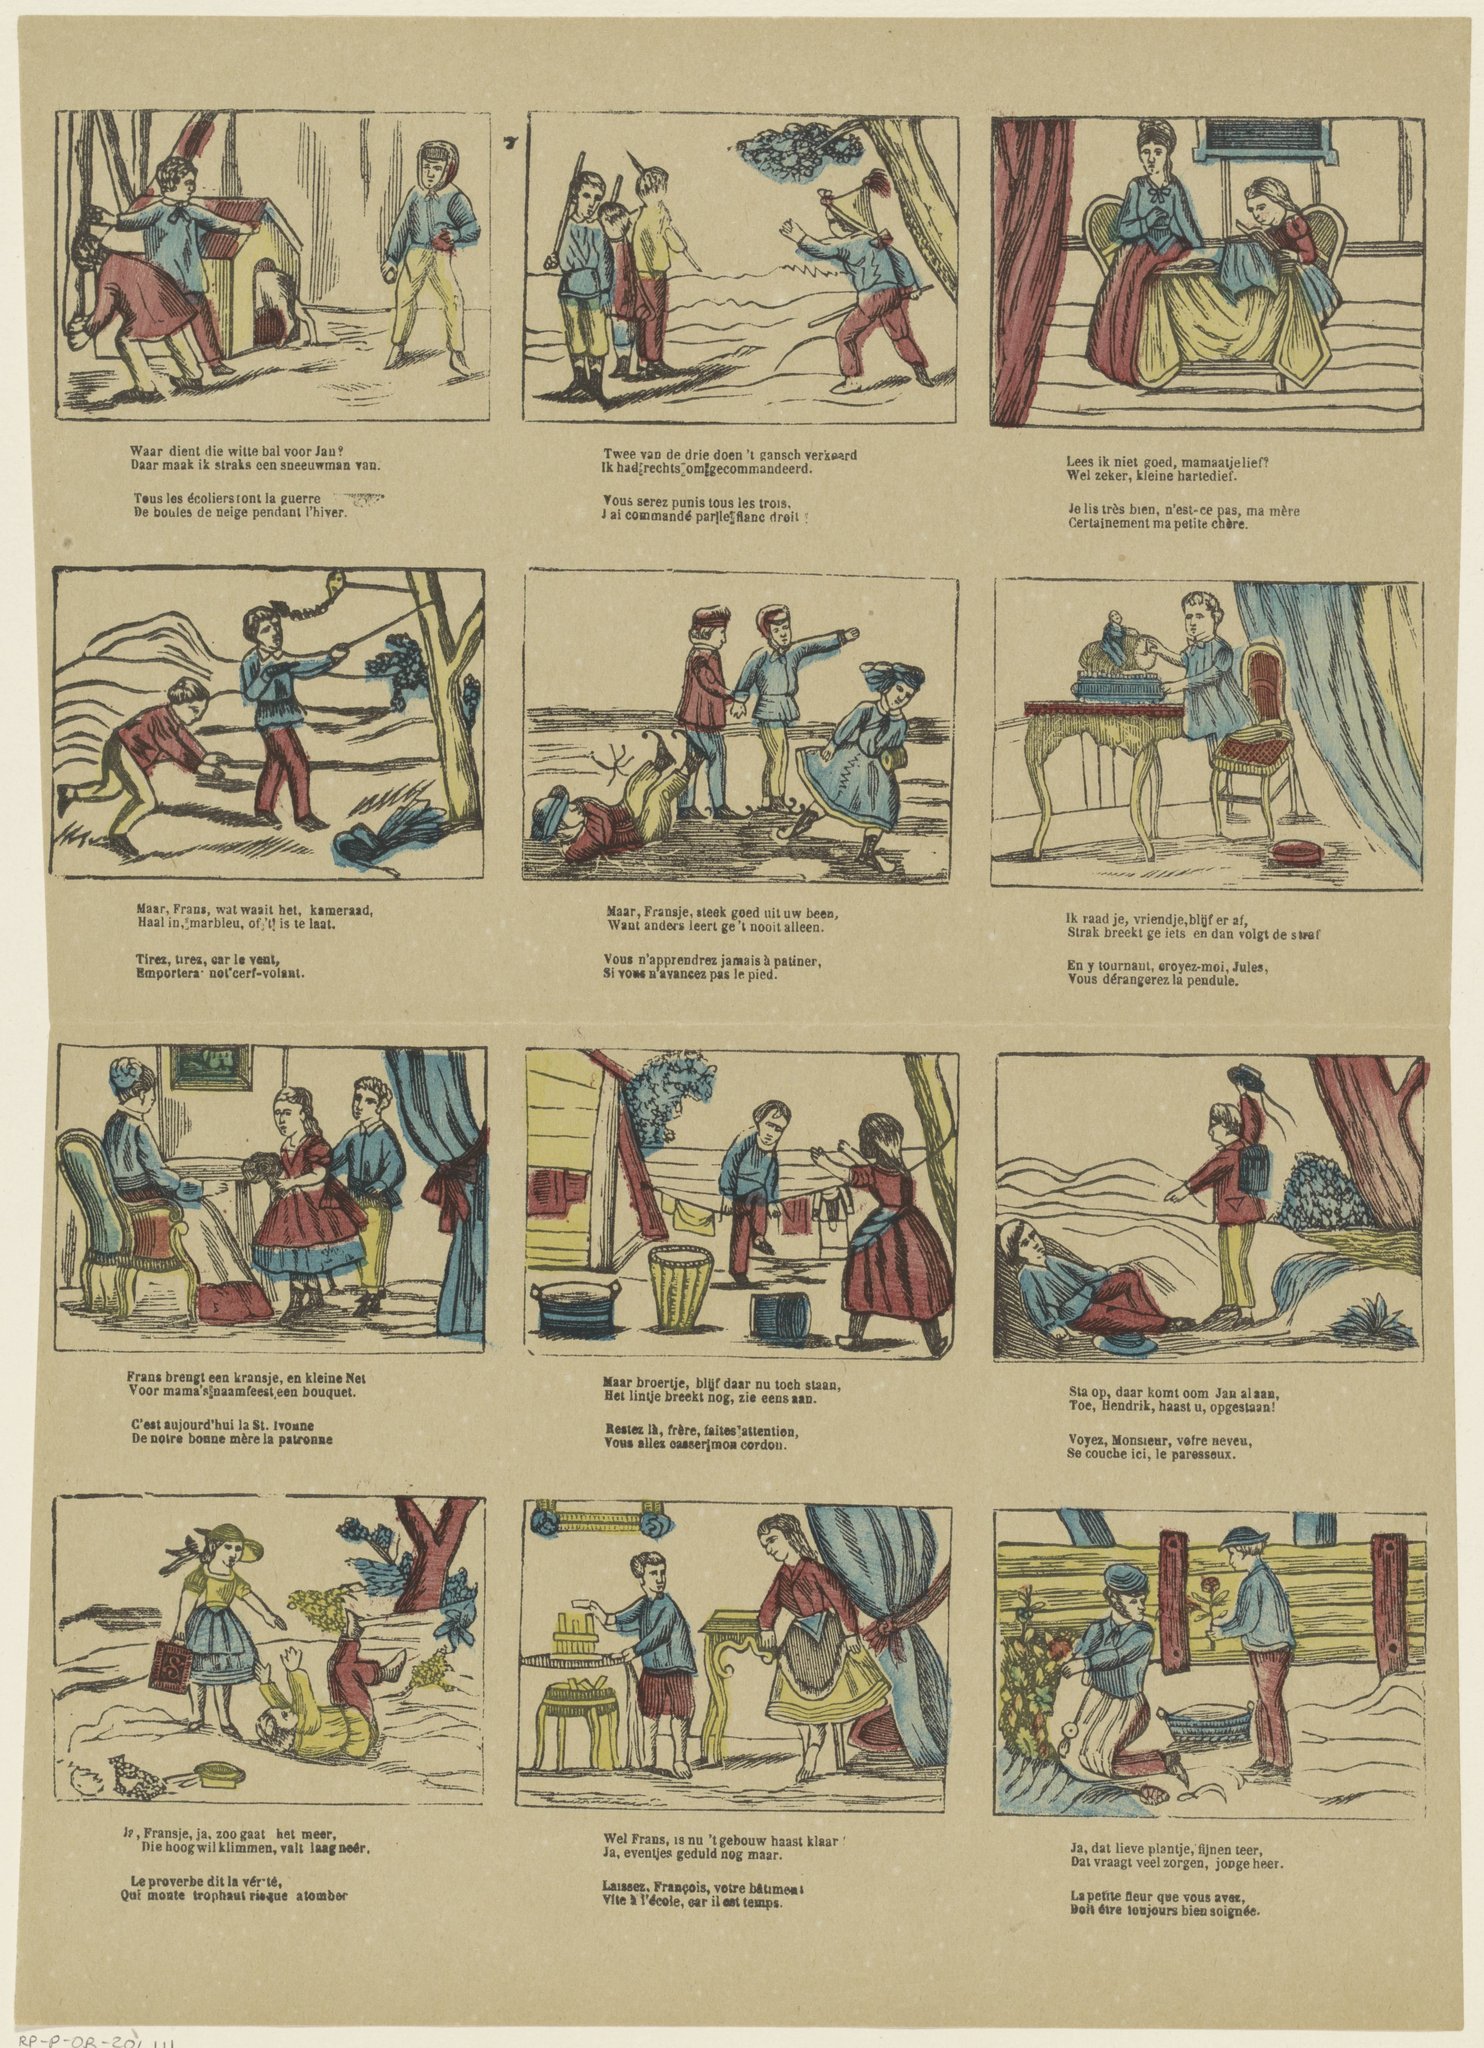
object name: print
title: Kinderbezigheden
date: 1866-1902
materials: paper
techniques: colour, letterpress printing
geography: europe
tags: children's games and plays, reading, child, gardening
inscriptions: collector's mark: Lugt 2760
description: Blad met 12 voorstellingen van kinderbezigheden, waaronder spelen, lezen en in de tuin werken. Onder elke voorstelling een tweeregelig vers in het Nederlands en in het Frans. Genummerd midden boven: 7.